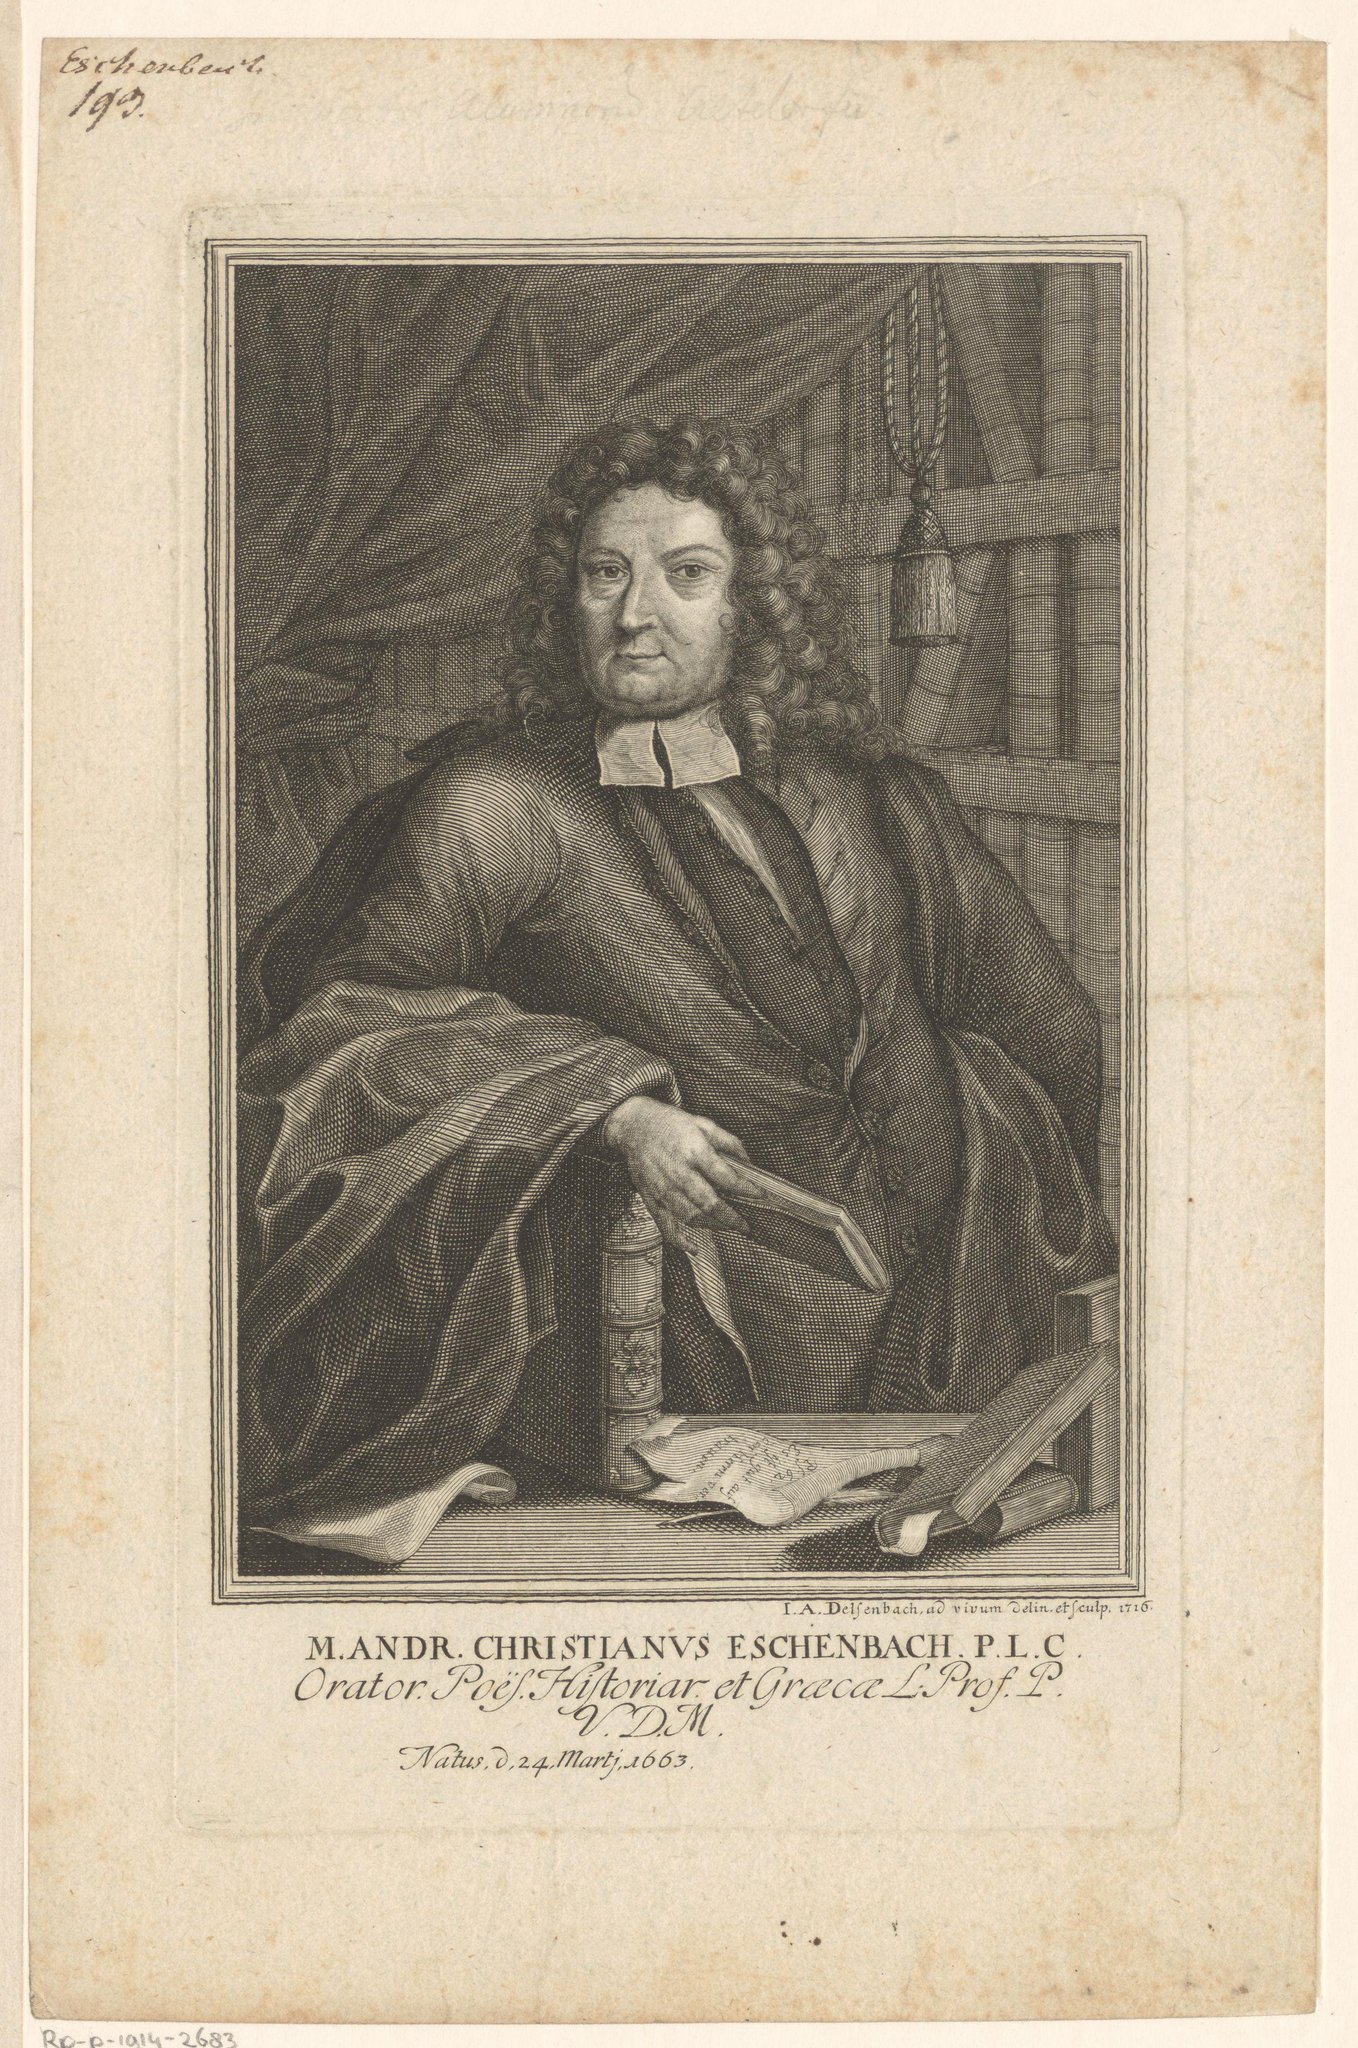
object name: print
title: M. Andr. Christianus Eschenbach P. L. C.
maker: johann adam delsenbach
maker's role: print maker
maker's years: 1687-1765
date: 1716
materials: paper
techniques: engraving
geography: nuremberg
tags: bookshelves, historical persons, book, letter, envelope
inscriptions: collector's mark: Lugt 2228